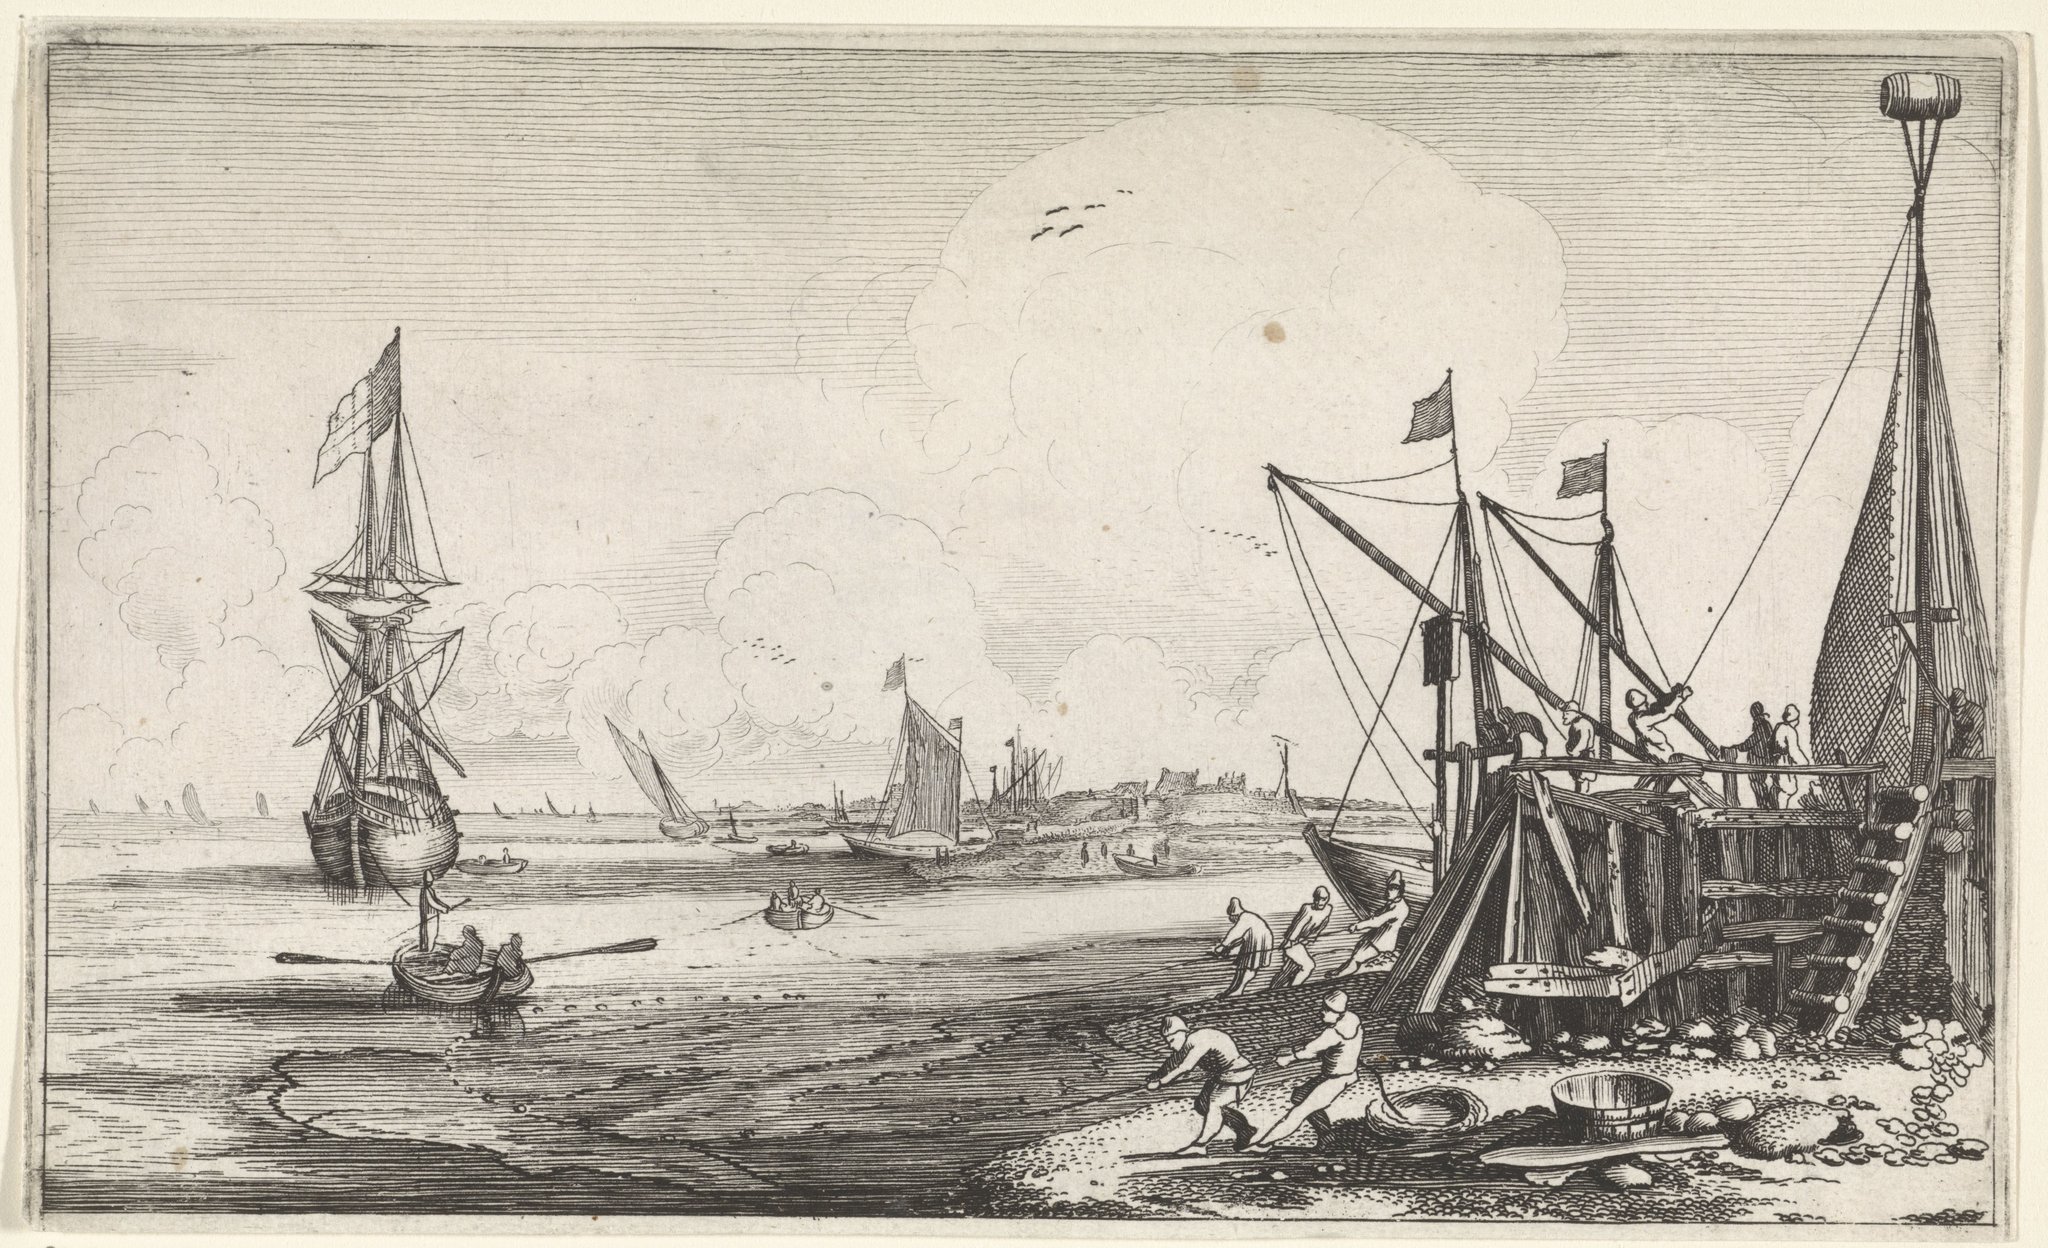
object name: print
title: Zeegezichten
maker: jan van de velde (ii)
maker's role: draughtsman, painter, print maker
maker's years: 1593-1641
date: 1603-1641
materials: paper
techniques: engraving, etching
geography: northern netherlands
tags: sailing-ship, sailing-boat, landscapes with waters, waterscapes, seascapes (in the temperate zone), ship bound for the harbour, beach, sea and coastal fishery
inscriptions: collector's mark: Lugt 2228, collector's mark: Lugt 2760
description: Vissers halen hun netten binnen bij een havenhoofd. Op het water zeilschepen en figuren in sloepen. Prent uit een serie van acht met marines.